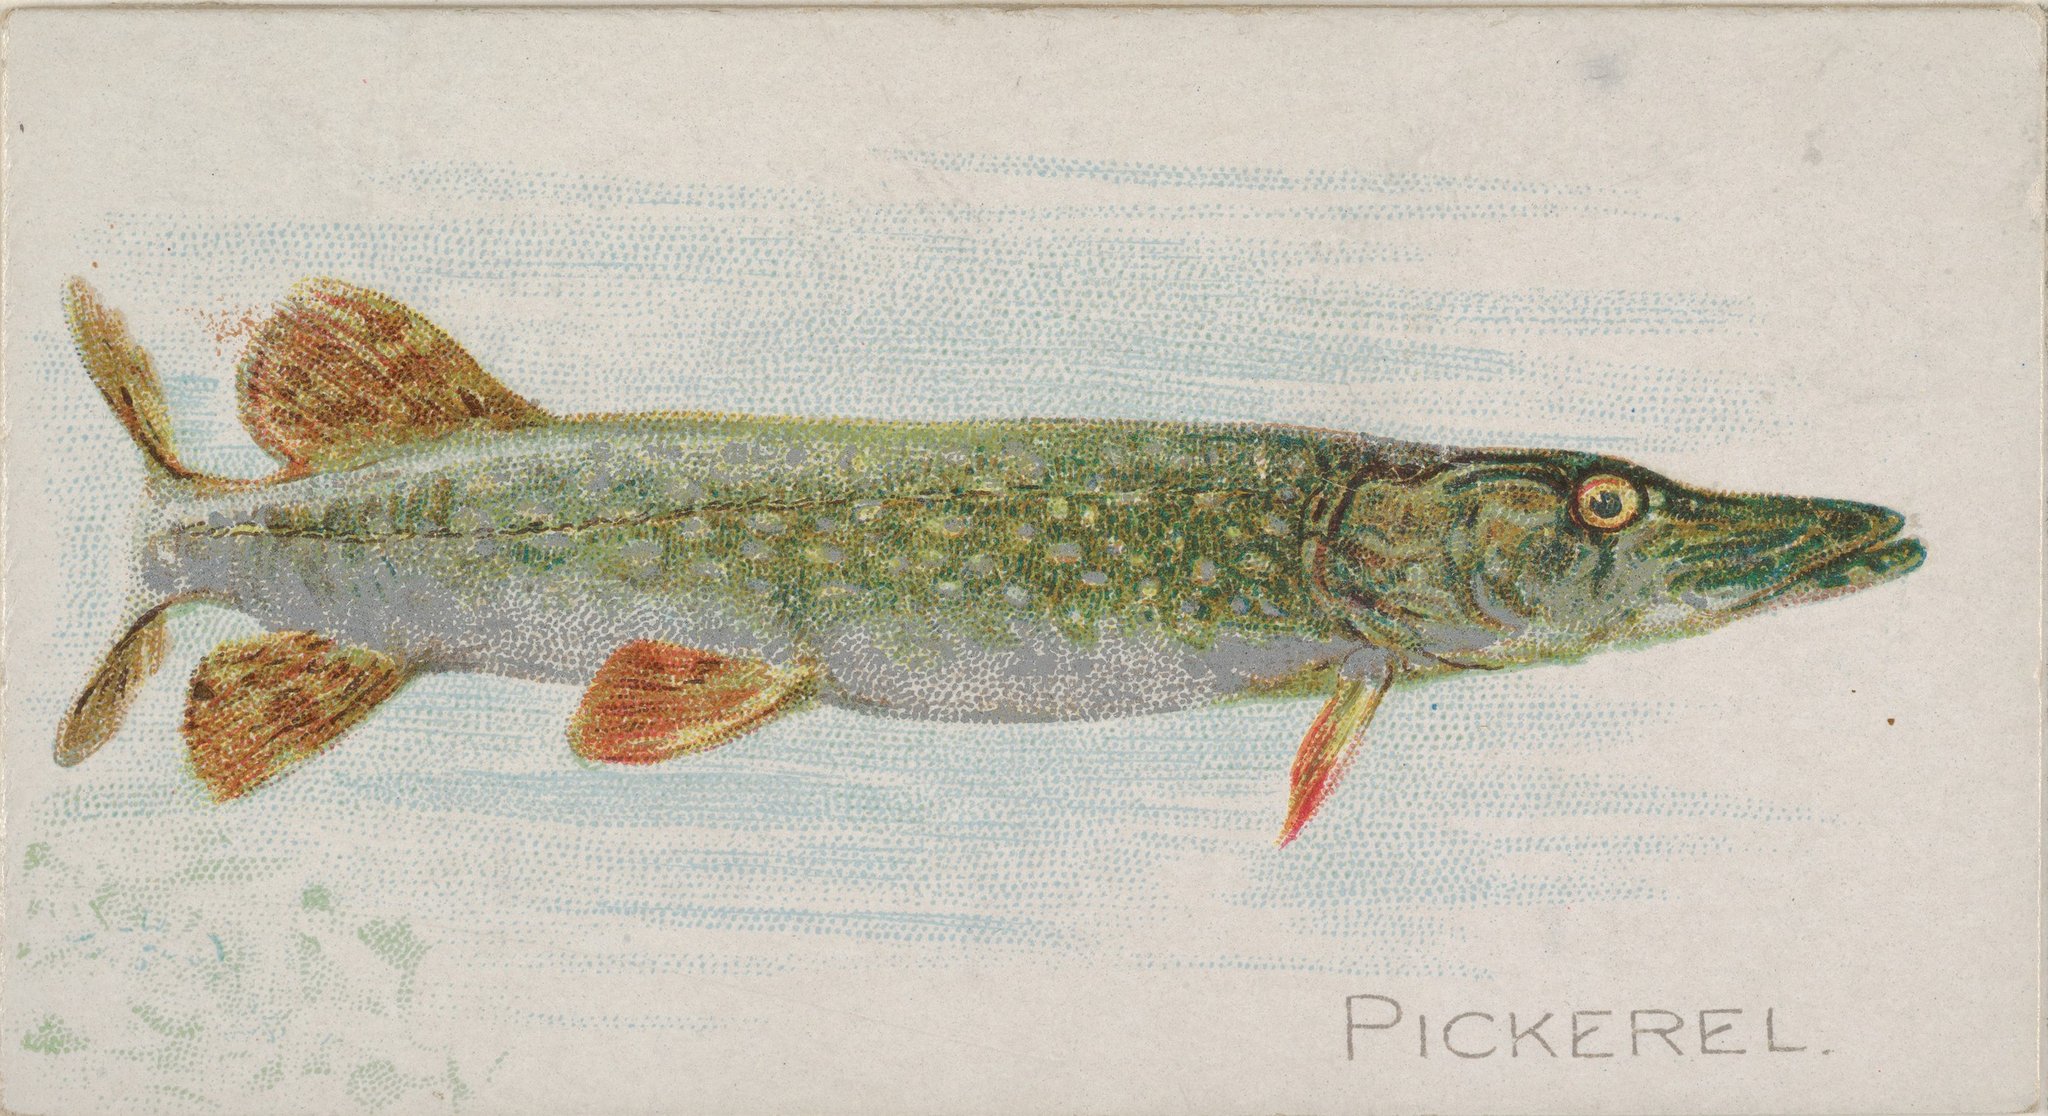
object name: print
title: Pickerel, from the Fish from American Waters series (N8) for Allen & Ginter Cigarettes Brands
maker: allen & ginter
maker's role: publisher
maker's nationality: american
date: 1889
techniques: color lithograph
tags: fish